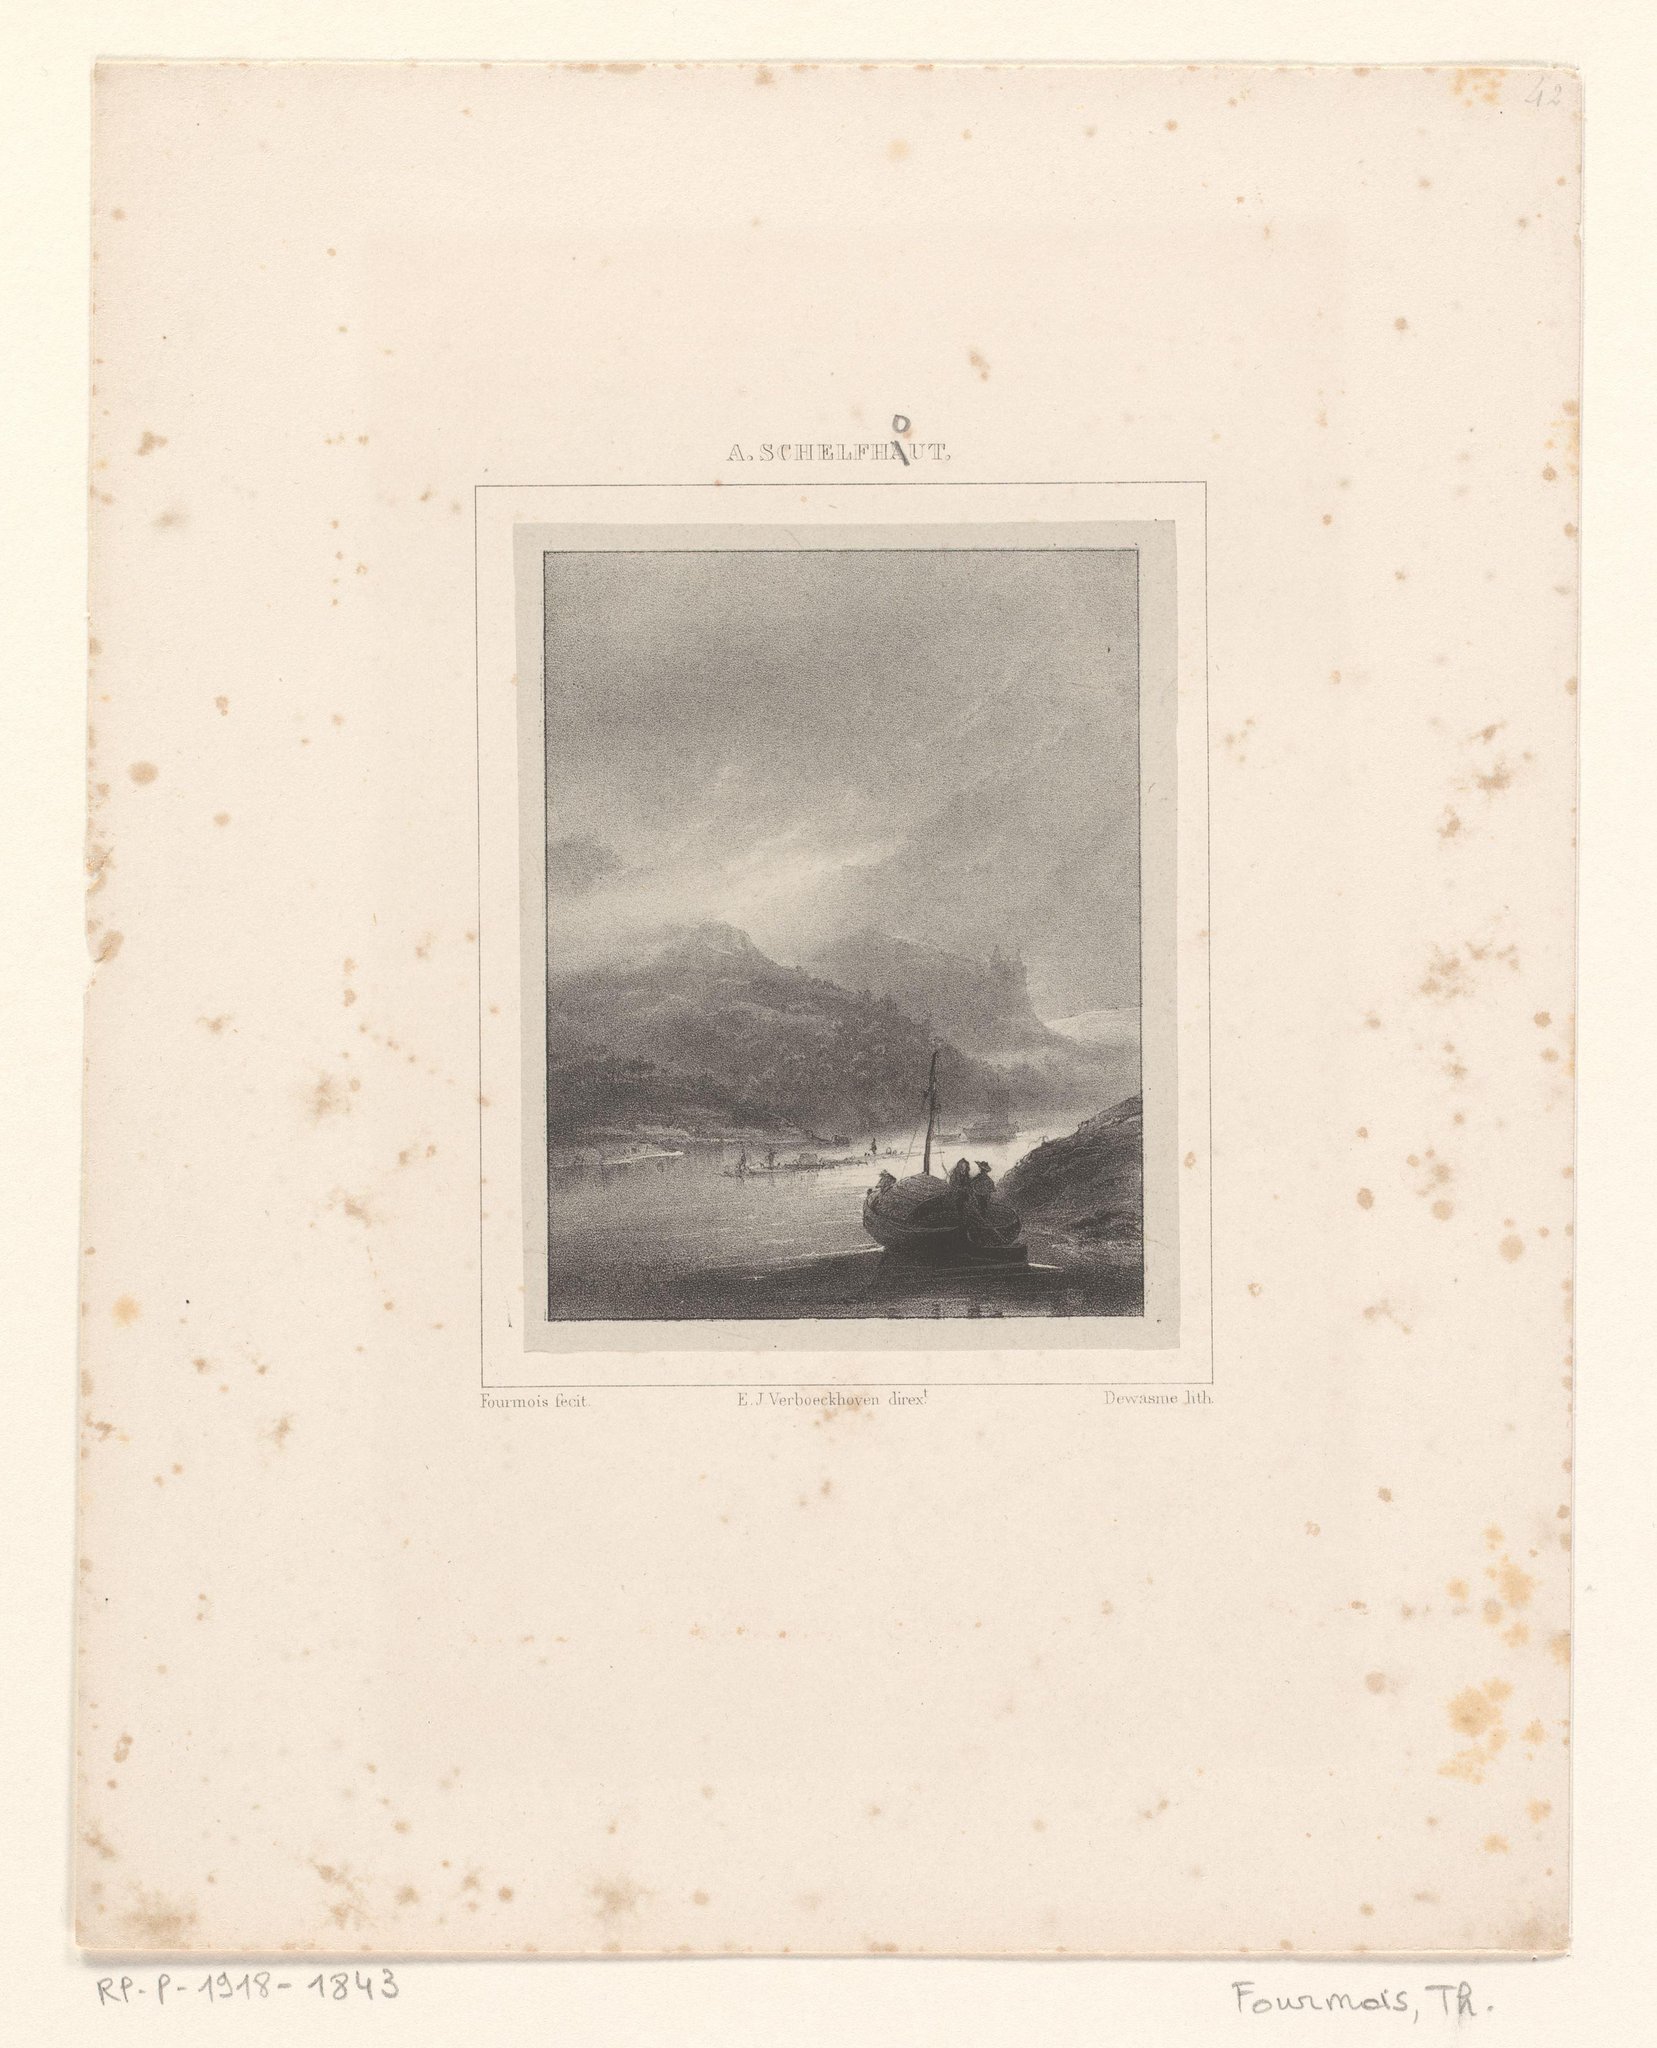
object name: print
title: Taferelen naar werken van andere kunstenaars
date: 1825-1827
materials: paper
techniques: lithograph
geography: brussels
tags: low hill country, sailing-ship, sailing-boat, river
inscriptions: collector's mark: Lugt 2233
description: Prent maakt waarschijnlijk deel uit van een serie met taferelen naar andere kunstenaars. Over deze serie is verder niets bekend.